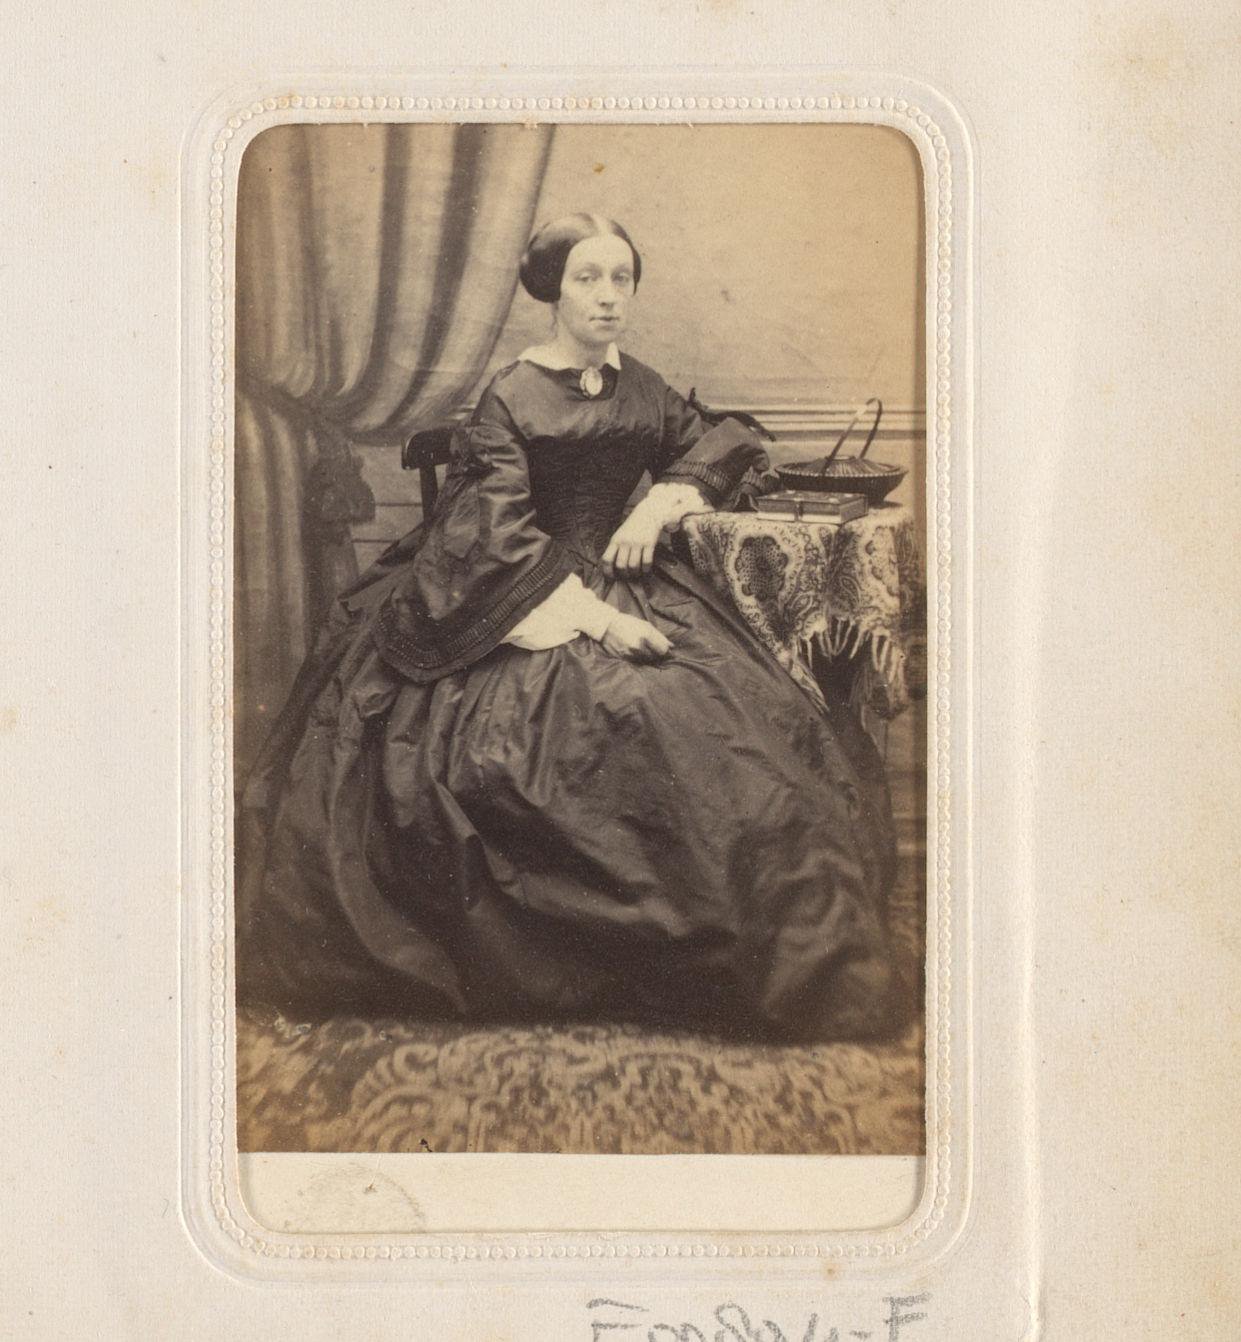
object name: photograph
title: Portret van een zittende vrouw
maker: Anonymous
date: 1860-1900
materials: cardboard, photographic support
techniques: albumen print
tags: sitting figure - aa - female human figure, historical persons